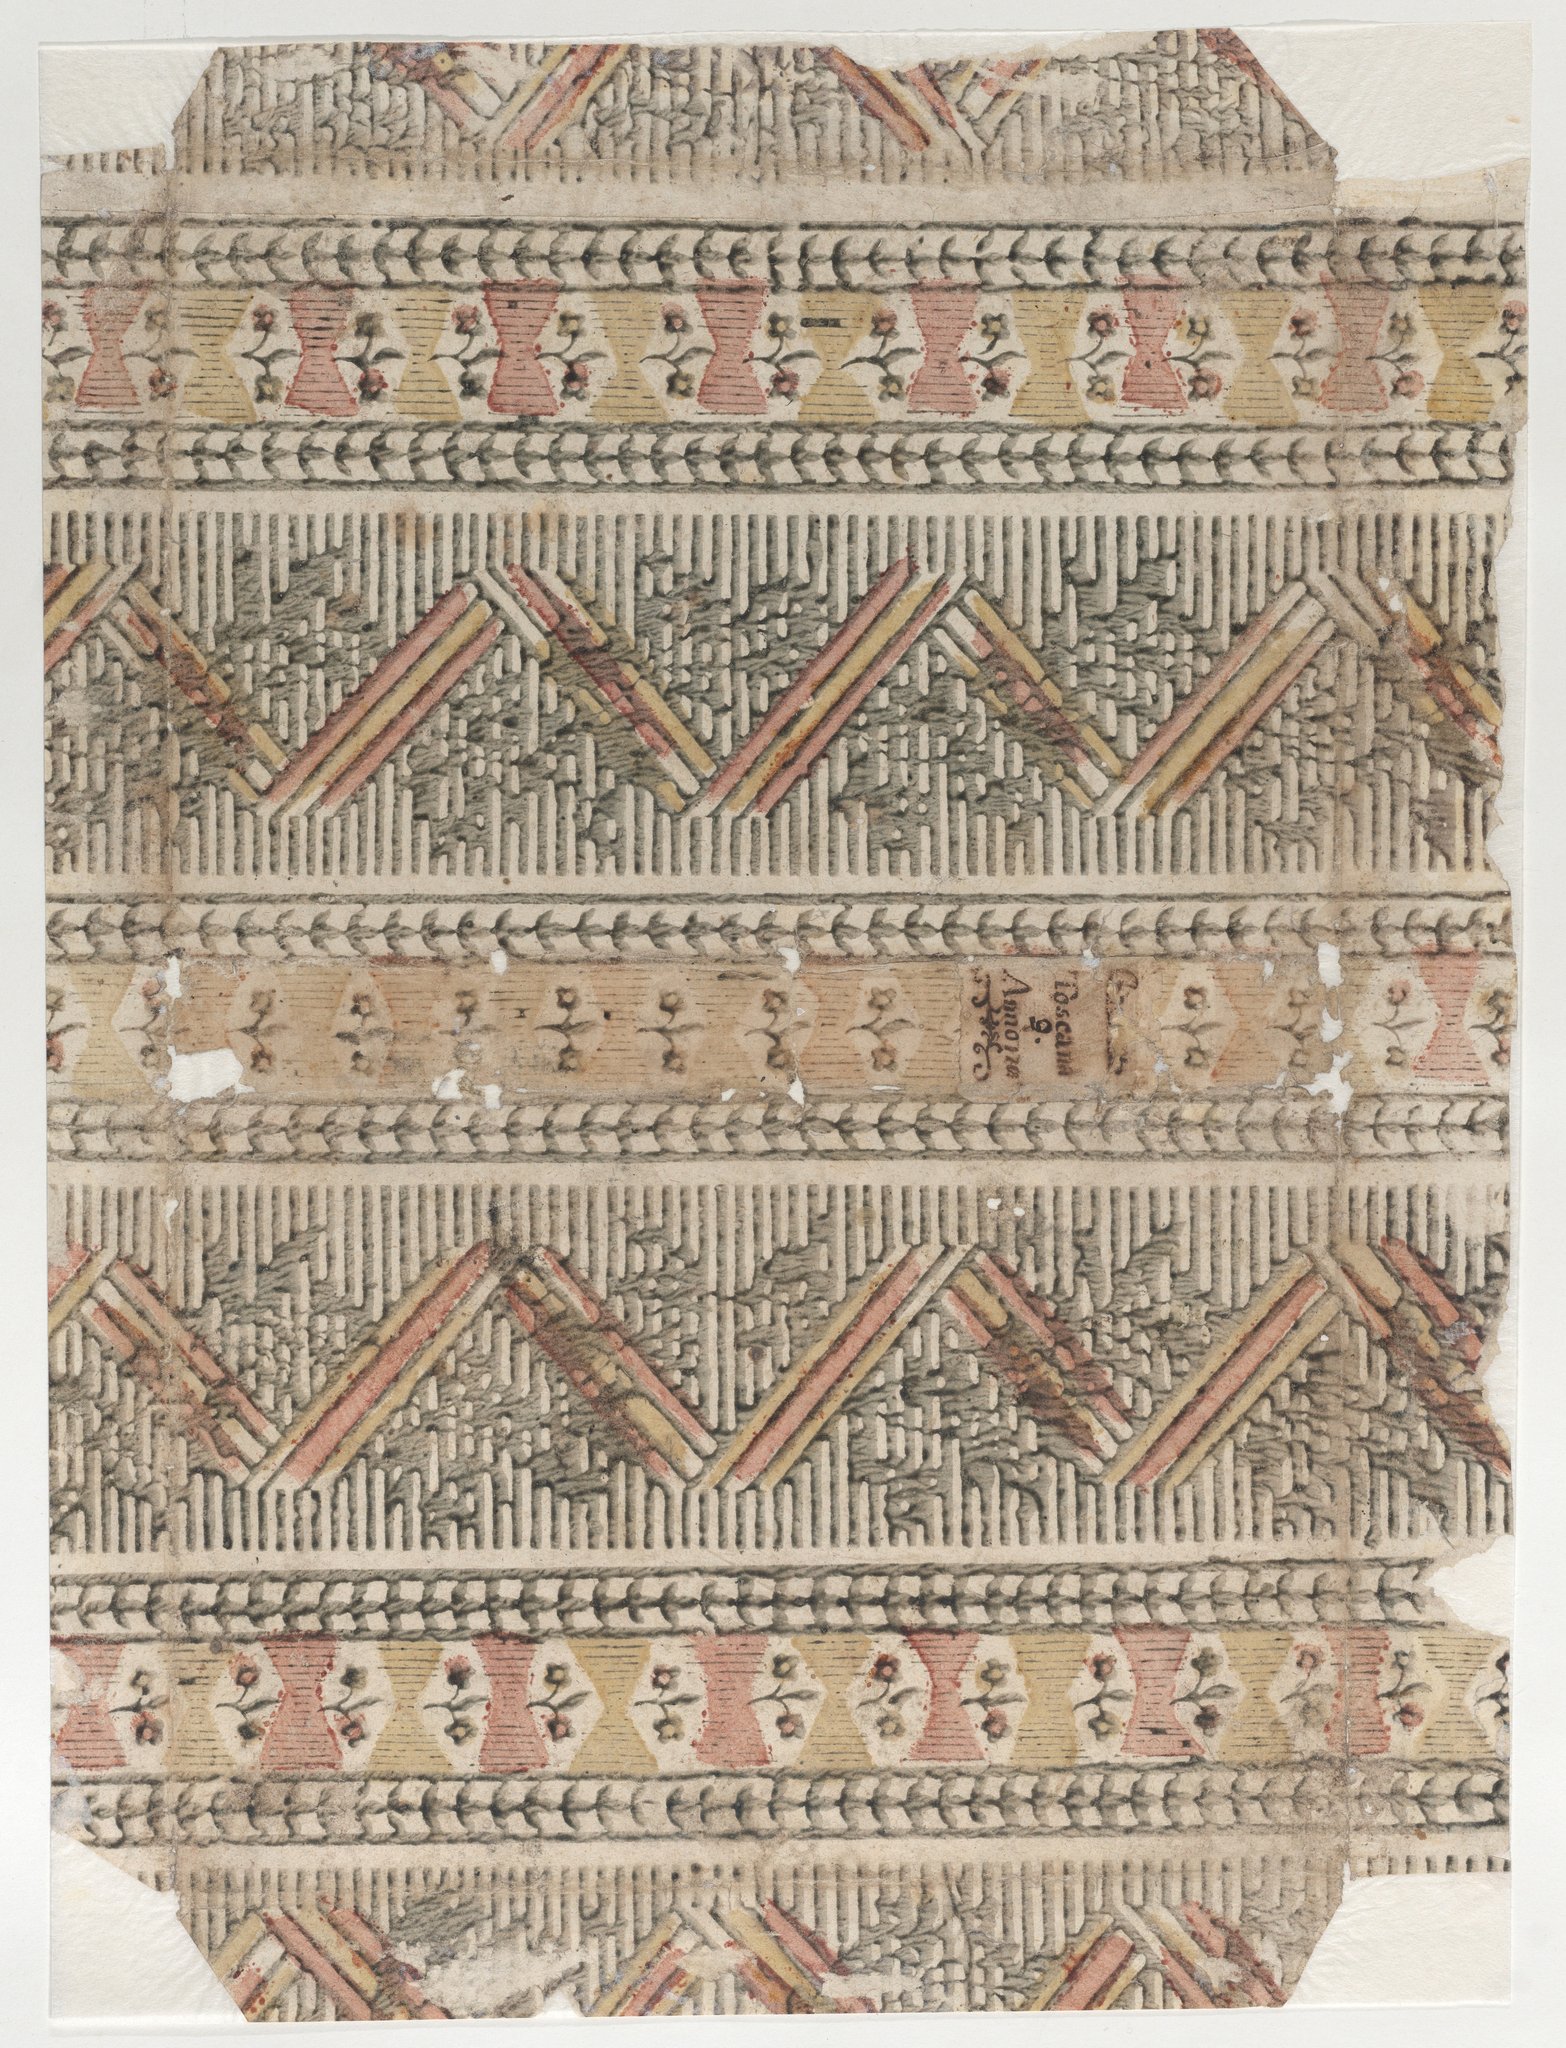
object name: print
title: Book cover with stripe, geometric, and floral pattern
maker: Anonymous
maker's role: artist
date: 1701-1800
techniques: relief print